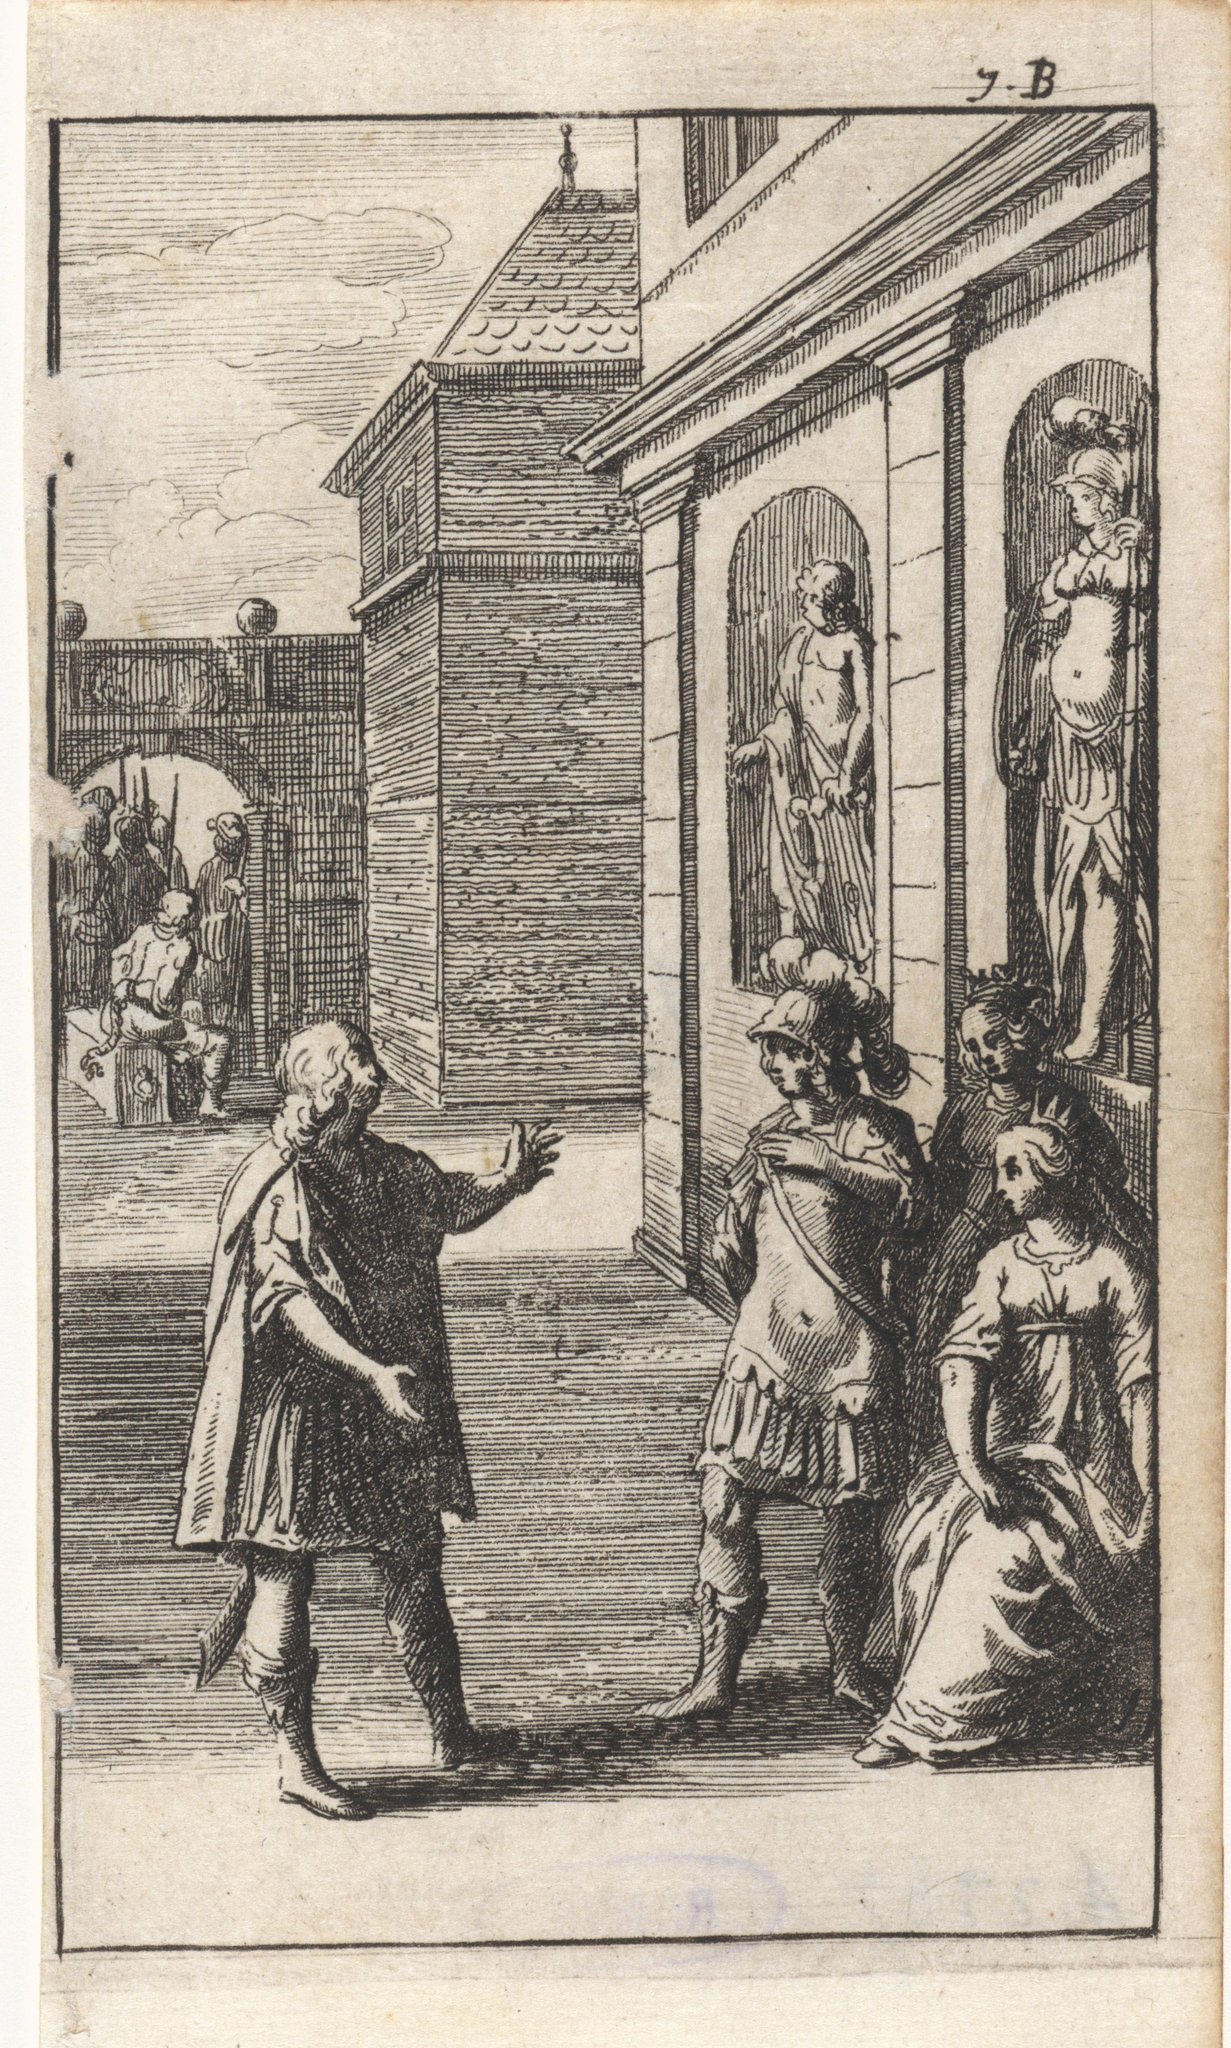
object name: print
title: Man voor een soldaat en twee vrouwen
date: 1666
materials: paper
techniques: etching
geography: amsterdam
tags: private soldier, ruler, sovereign - bb - female ruler, gate, entrance, prisoner with hands bound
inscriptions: collector's mark: Lugt 2228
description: Vooraan staat een man voor een soldaat en twee gekroonde vrouwen, onder wie Cleopatra Selene II(?). Achter hen een classicistisch gebouw met een beeld van Minerva. Links in de verte zit een gevangene op een bank bij een toegangspoort met soldaten. Rechtsboven: 7. B.